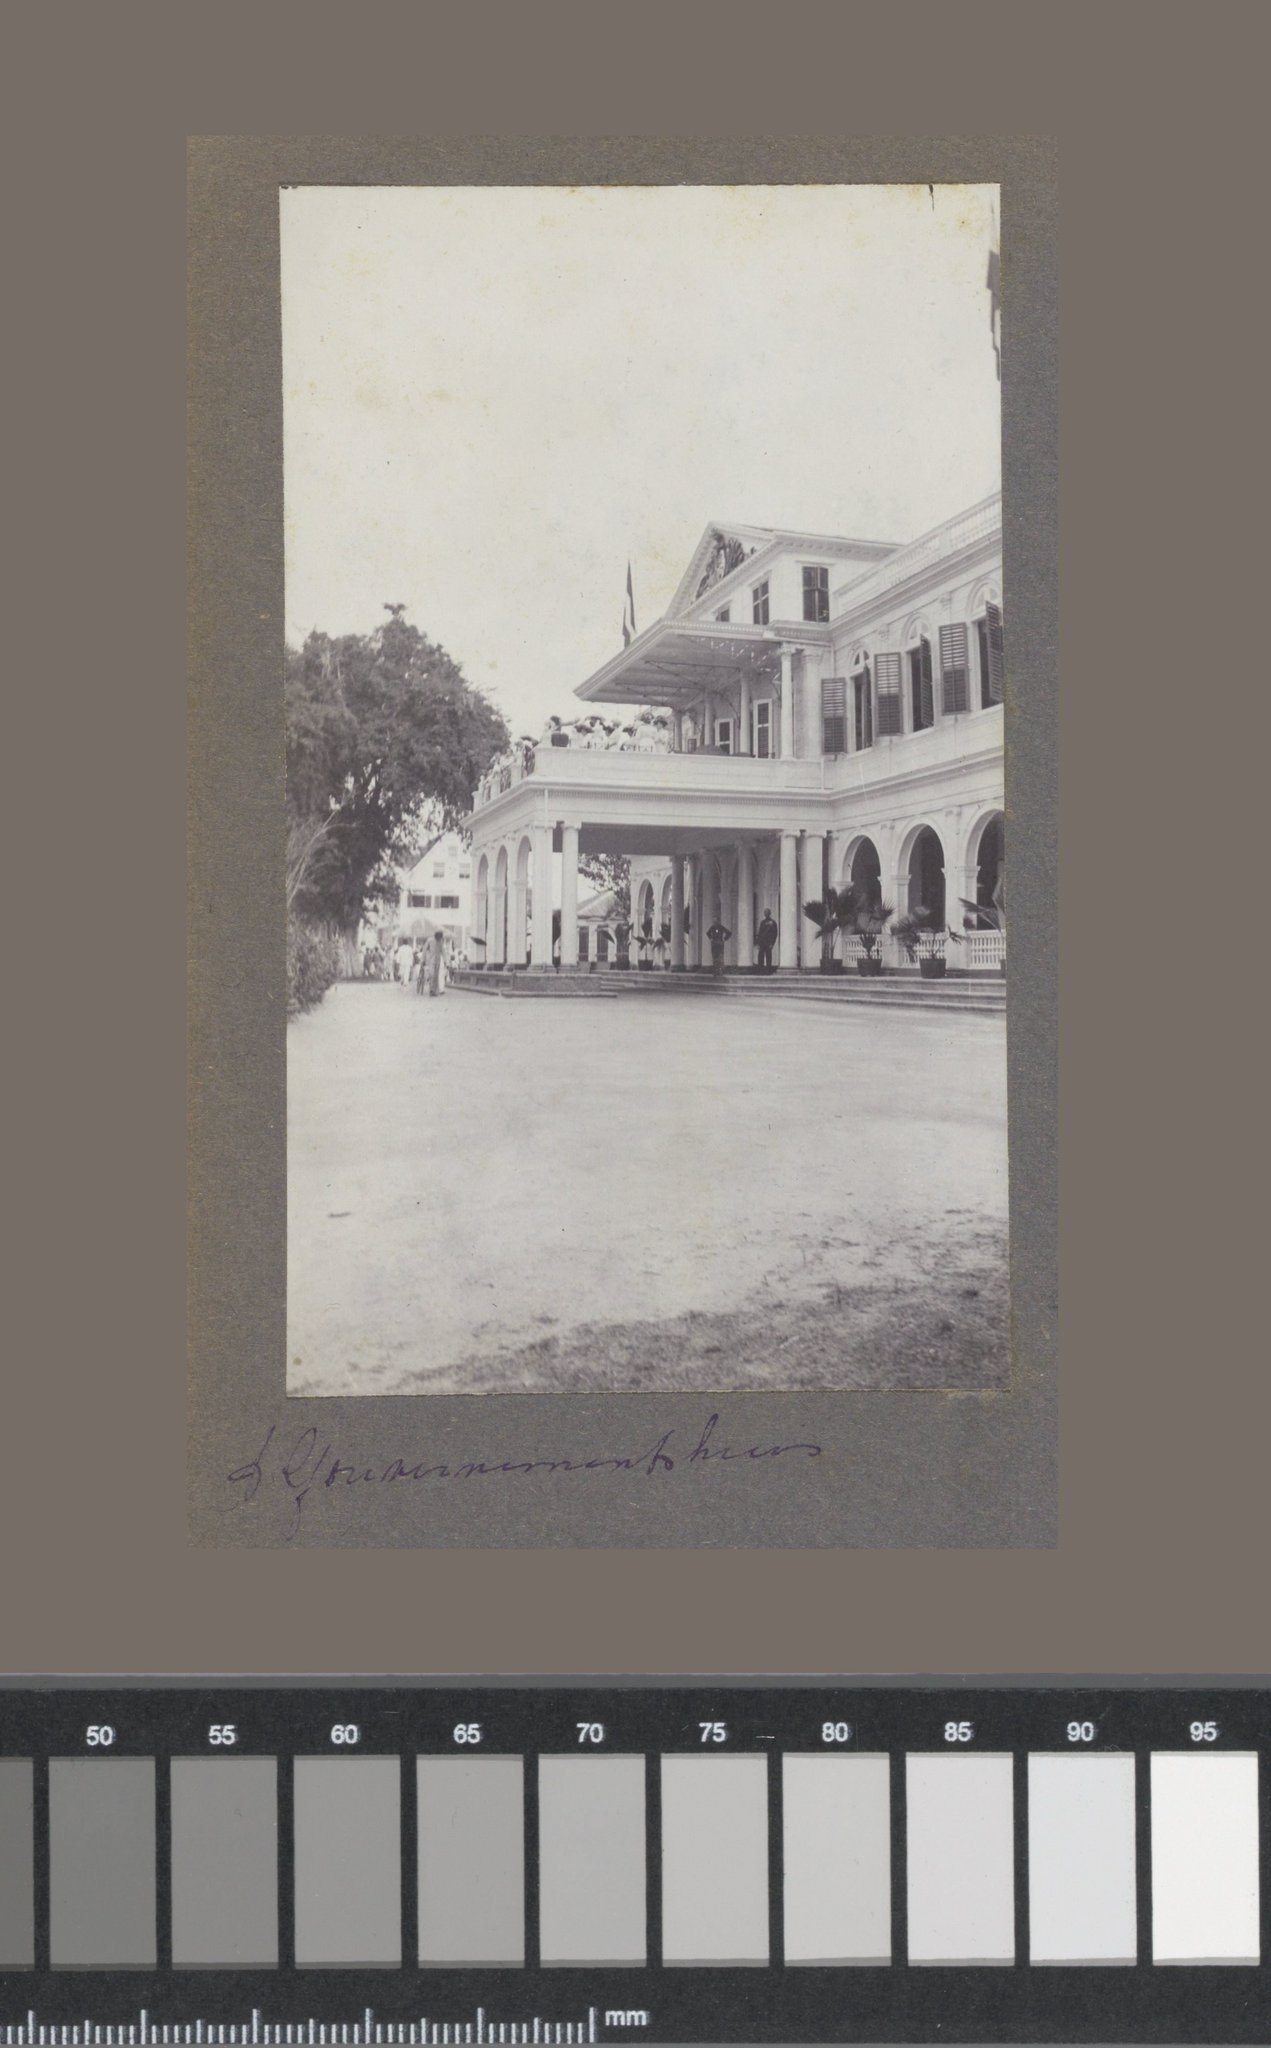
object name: photograph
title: Gouvernementshuis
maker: Anonymous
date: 1912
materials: photographic support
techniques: photography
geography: suriname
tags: national government, suriname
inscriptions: inscription: ‘t Gouvernementshuis’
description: Gezicht op het Gouvernementshuis in Paramaribo. Onderdeel van het fotoalbum over het leven van de familie Gonggrijp in Suriname rond 1912.